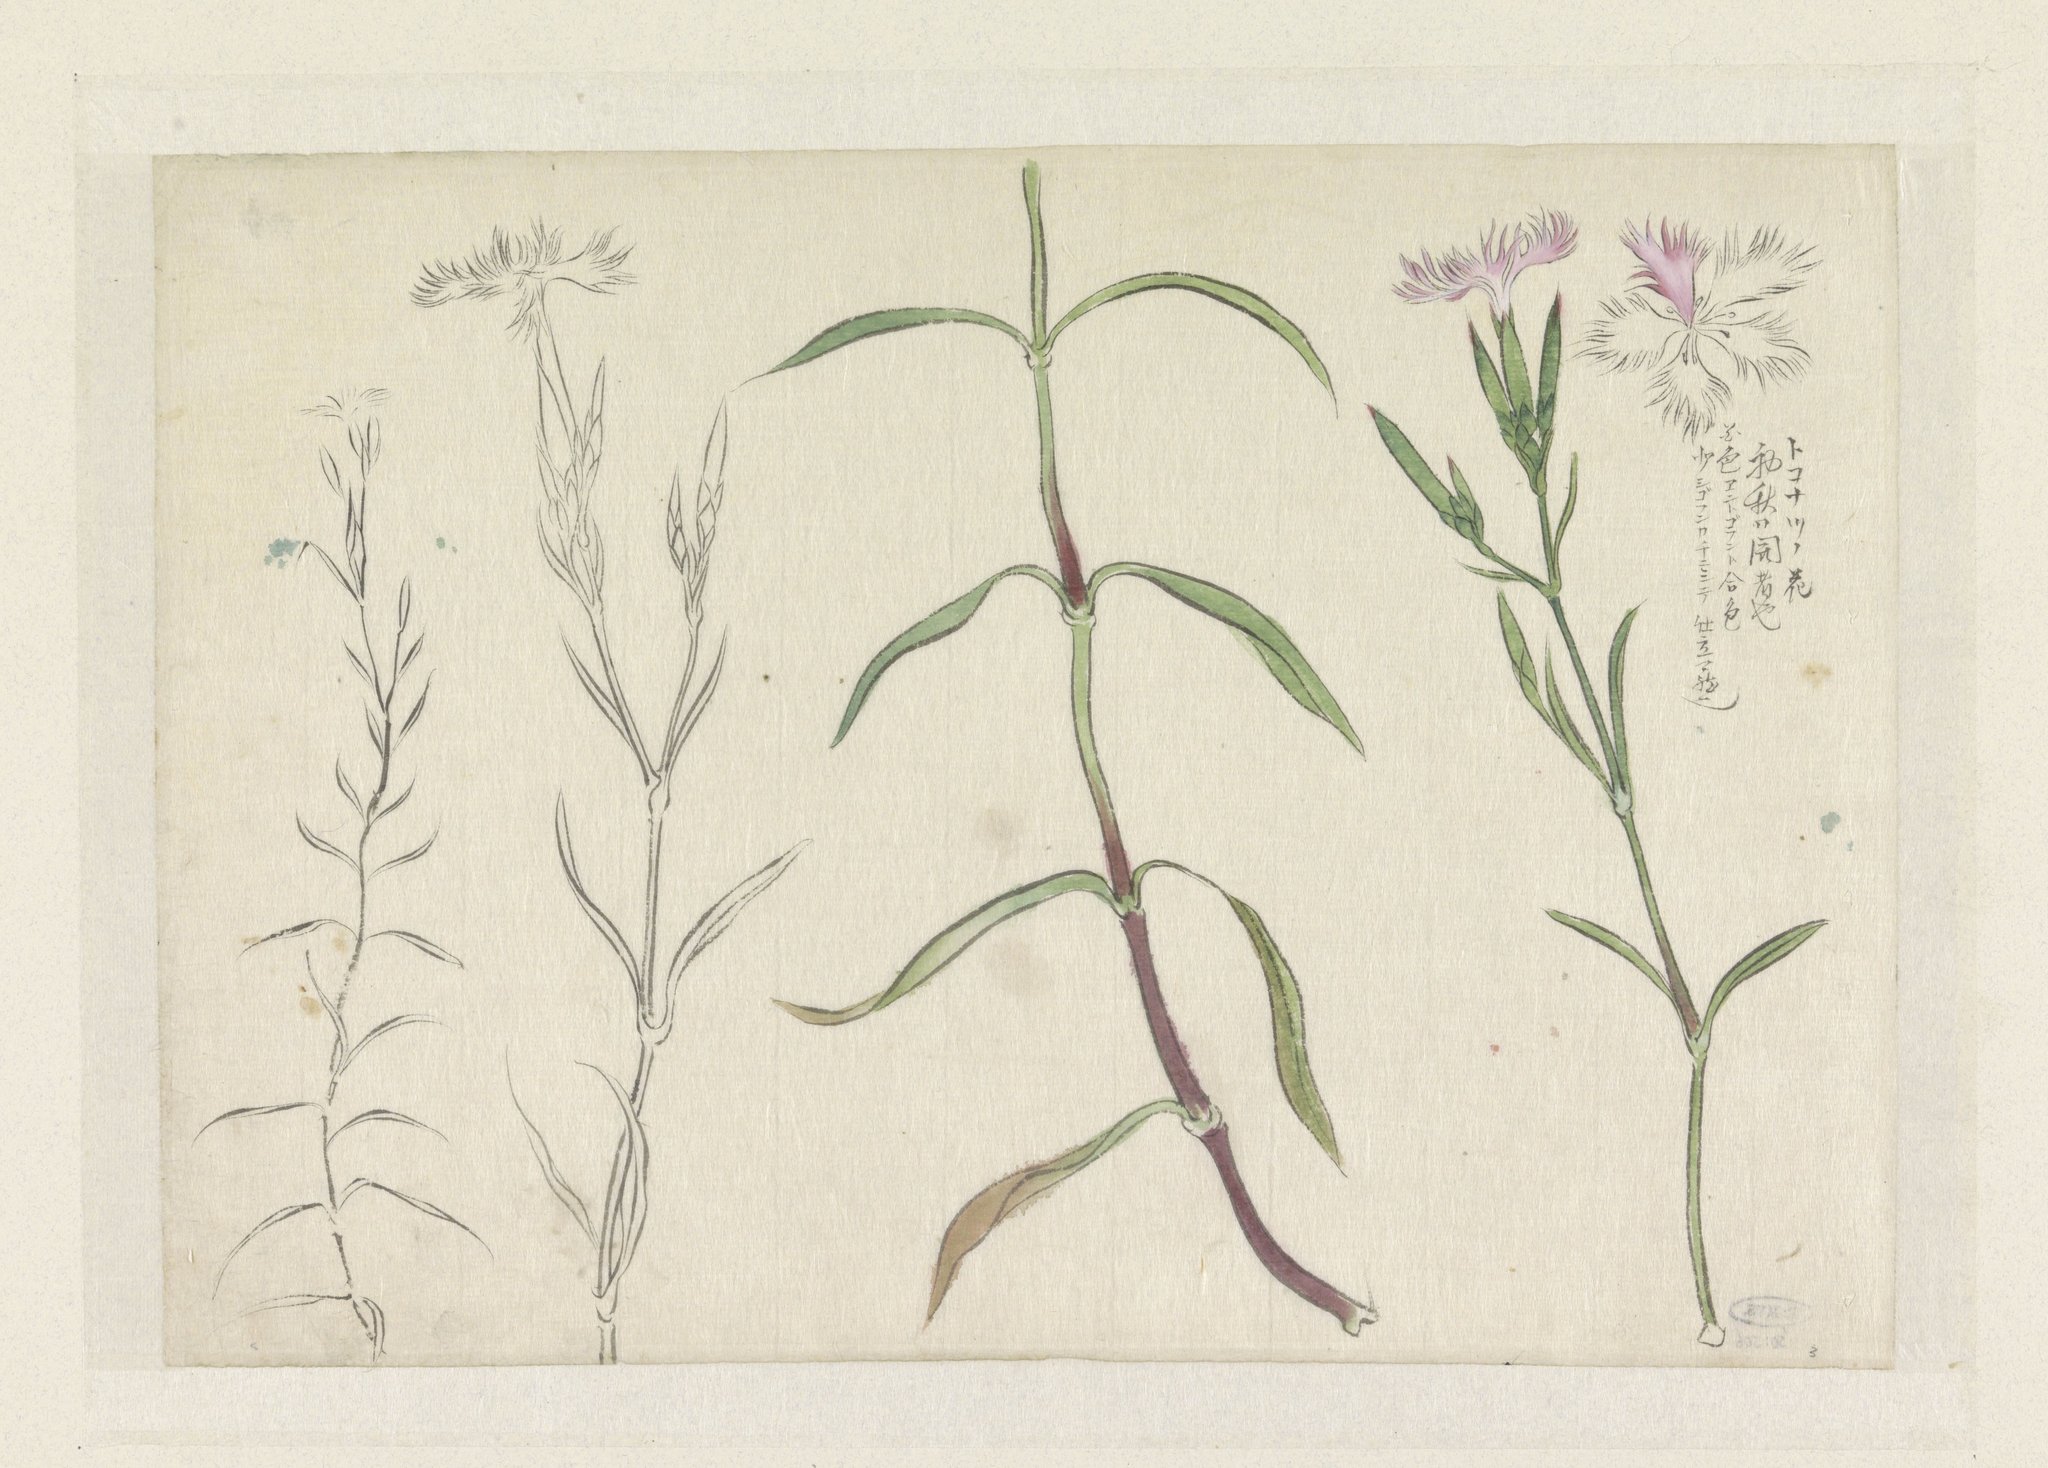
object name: drawing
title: Schetsblad met studies van een wilde anjelier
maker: ishikawa kazan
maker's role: draughtsman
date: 1800-1900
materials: paper, watercolor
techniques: brush